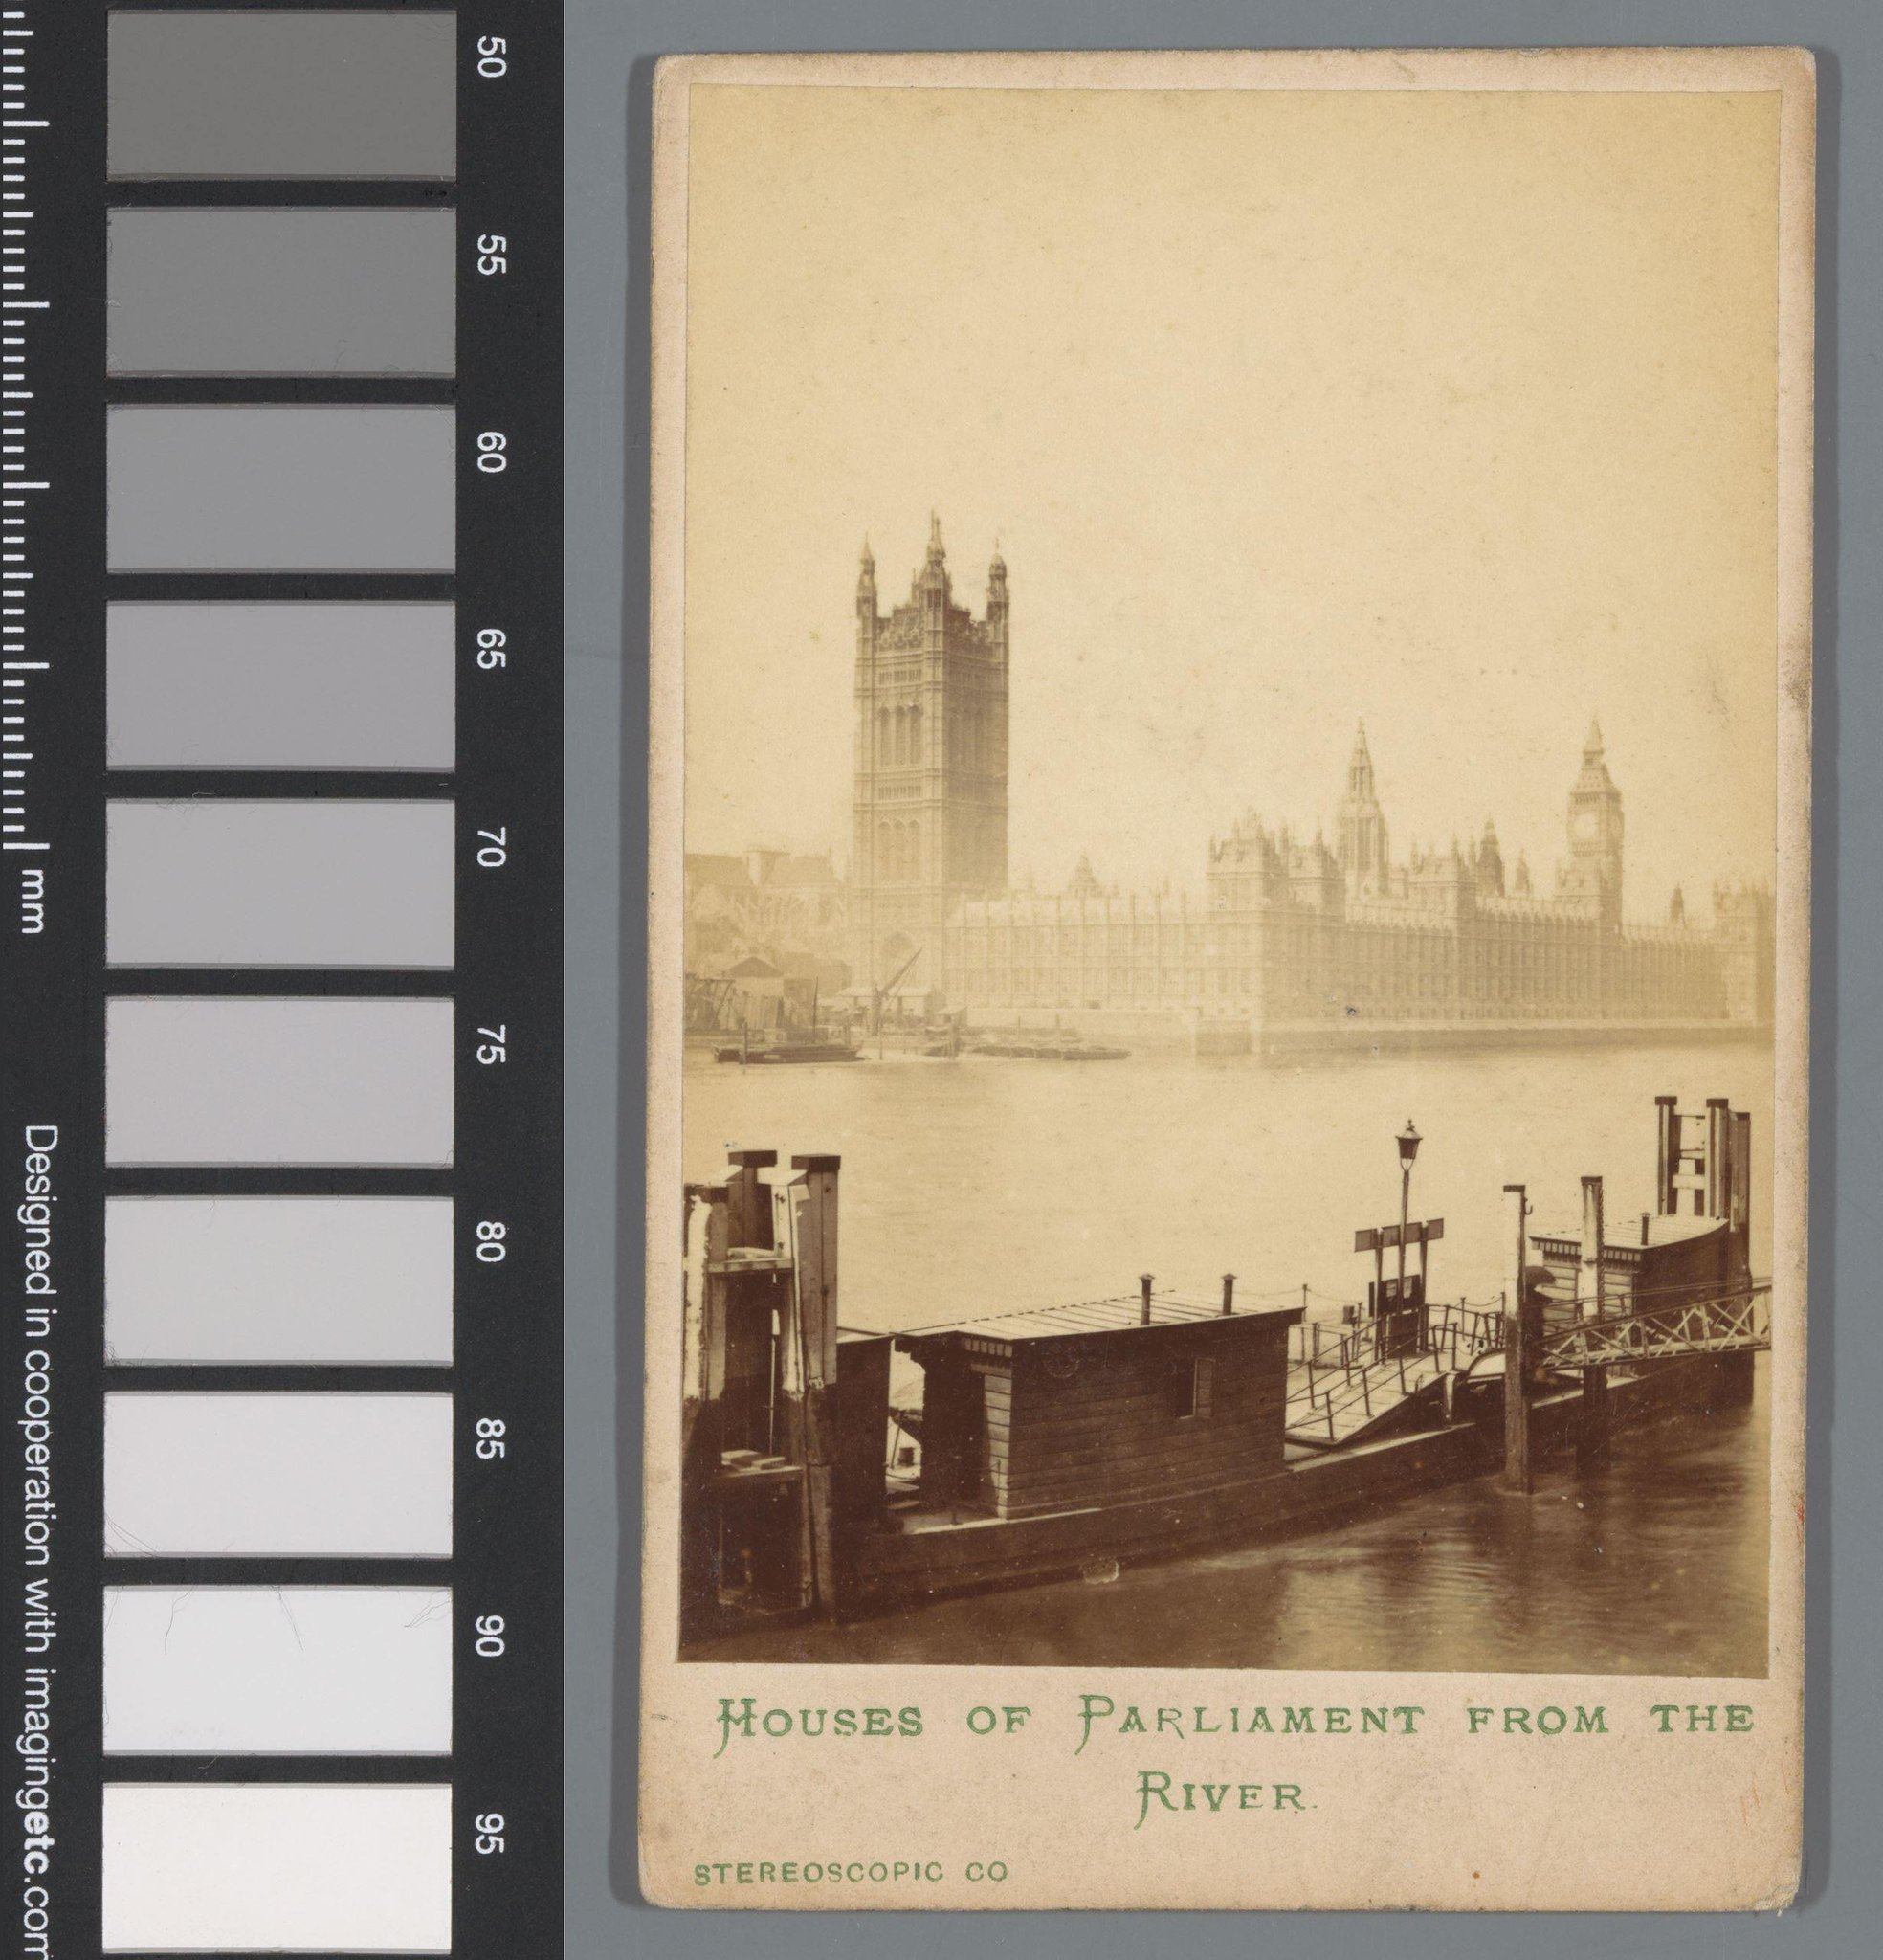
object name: photograph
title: Palace of Westminster gezien vanaf de Theems, Londen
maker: Anonymous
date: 1870-1885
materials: cardboard, paper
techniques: albumen print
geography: london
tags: exterior ~ representation of a building, lower house, parliament, chamber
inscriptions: inscription: ‘PHOTOGRAPHERS TO H.R.H. THE PRINCE OF WALES,/ AND/ TO H.R.H. THE DUKE OF EDINBURGH./ BERLIN/ LONDON/ DUBLIN/ NEW YORK/ SOLE PHOTOGRAPHERS TO THE INTERNATIONAL EXHIBITION 1862/ THE LONDON/ STEREOSCOPIC & PHOTOGRAPHIC/ COMPANY/ 110 & 108, REGENT STREET,/ AND/ 54, CHEAPSIDE./ THIS NEGATIVE IS PRESERVED FOR FURTHER COPIES./ ENLARGEMENTS CAN AT ANY TIME BE PRODUCED/ WITHOUT ANOTHER SITTING.’